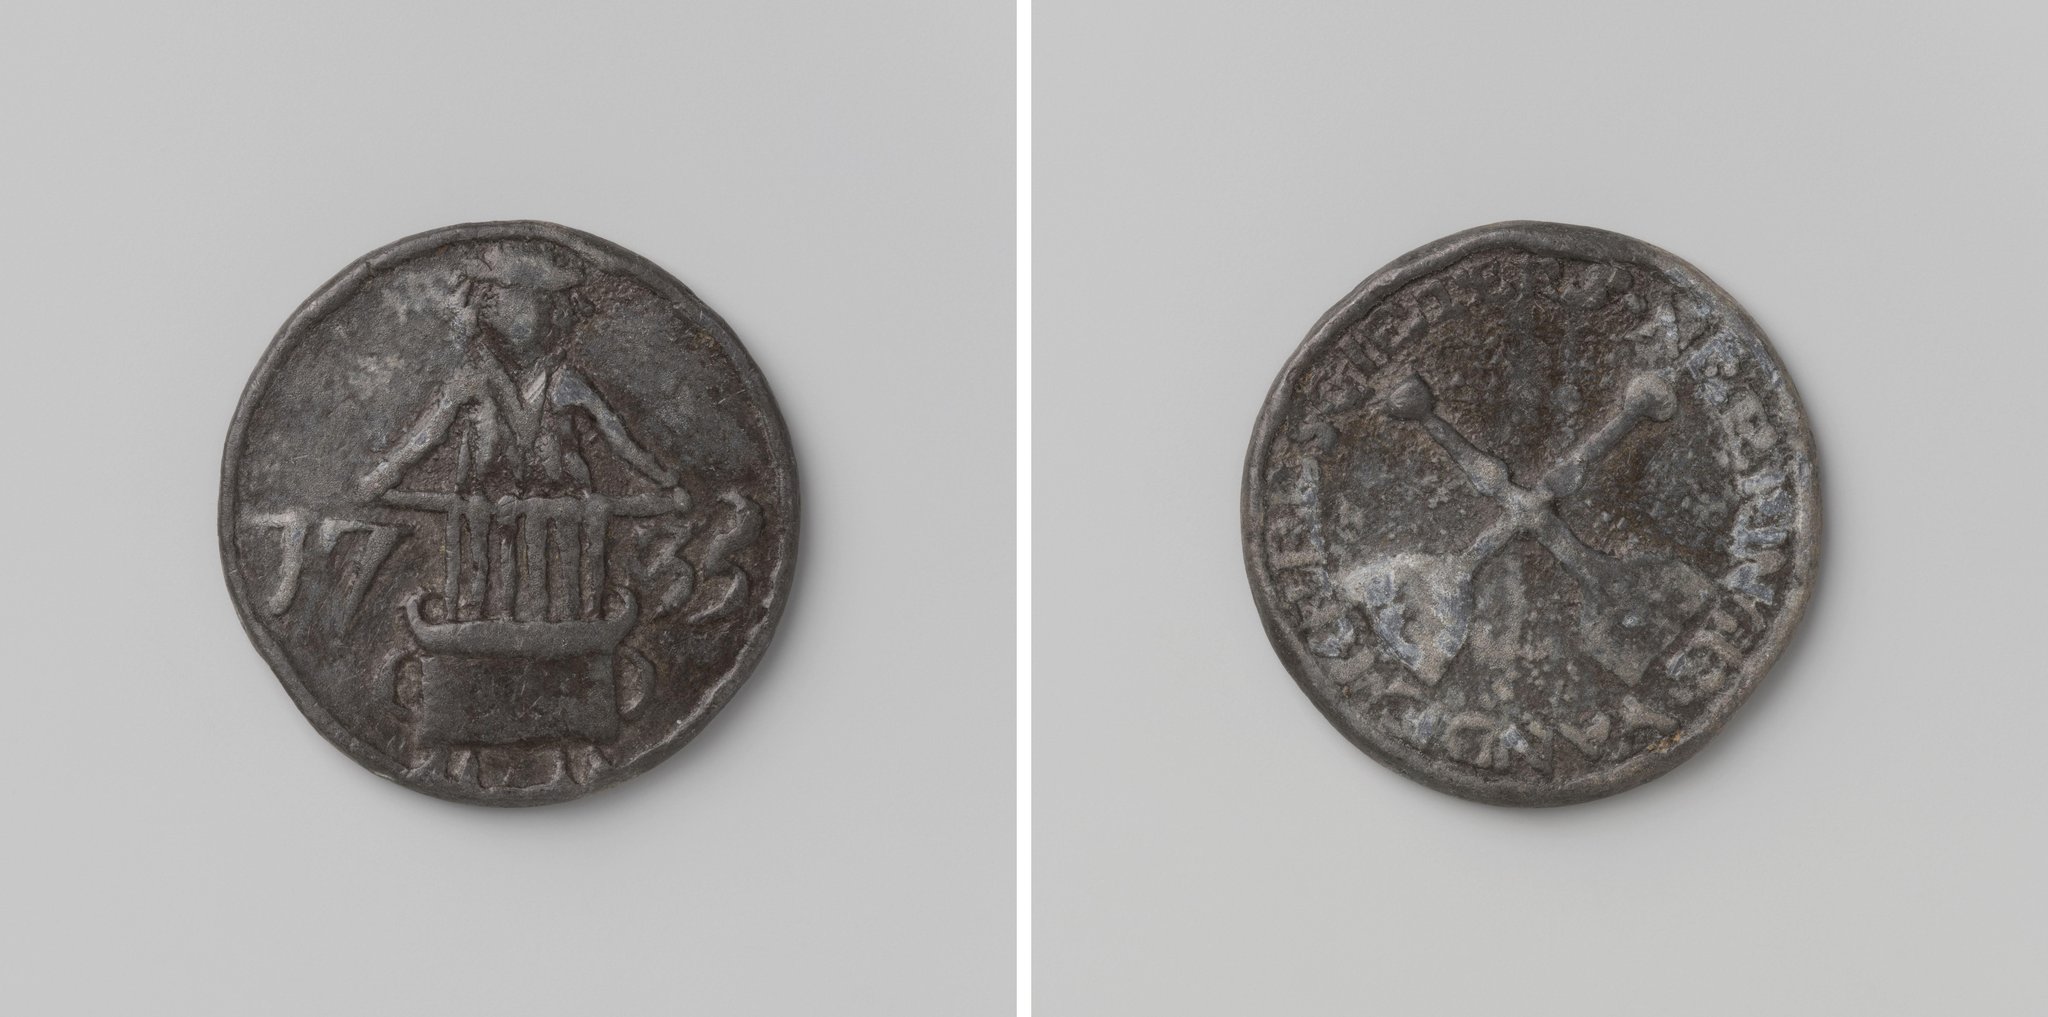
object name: alms token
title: Kaarsenmakersgilde van Gent, penning die bij uitdeling onder de armen recht op brood gaf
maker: Anonymous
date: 1735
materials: lead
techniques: casting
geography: ghent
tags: ghent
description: Loden penning. Voorzijde: man die zes aan stok hangende kaarsen uit ketel tilt tussen jaartal. Keerzijde: twee gekruiste voorwerpen binnen omschrift. Vermoedelijk een armenloodje.